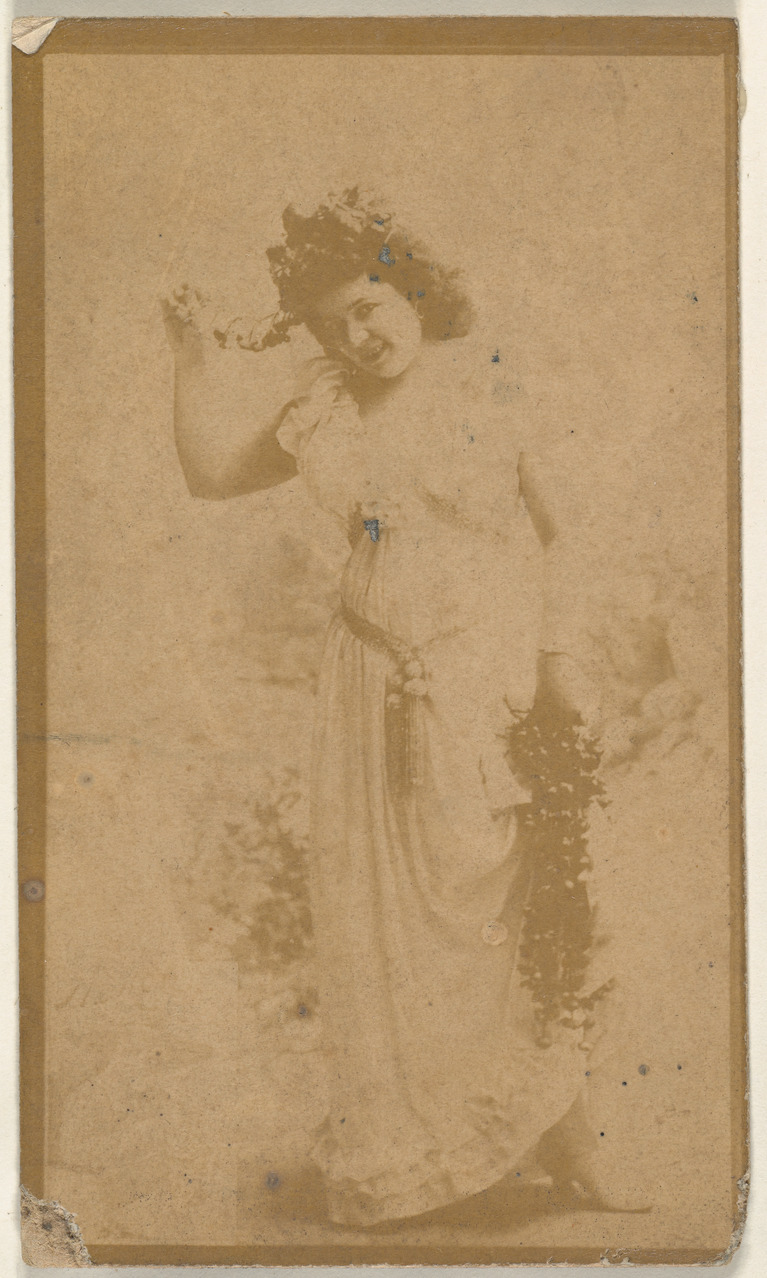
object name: photograph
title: Actress wearing headpiece of floral vines, from the Actresses series (N668)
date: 1888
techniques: albumen silver print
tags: portraits,women,actresses